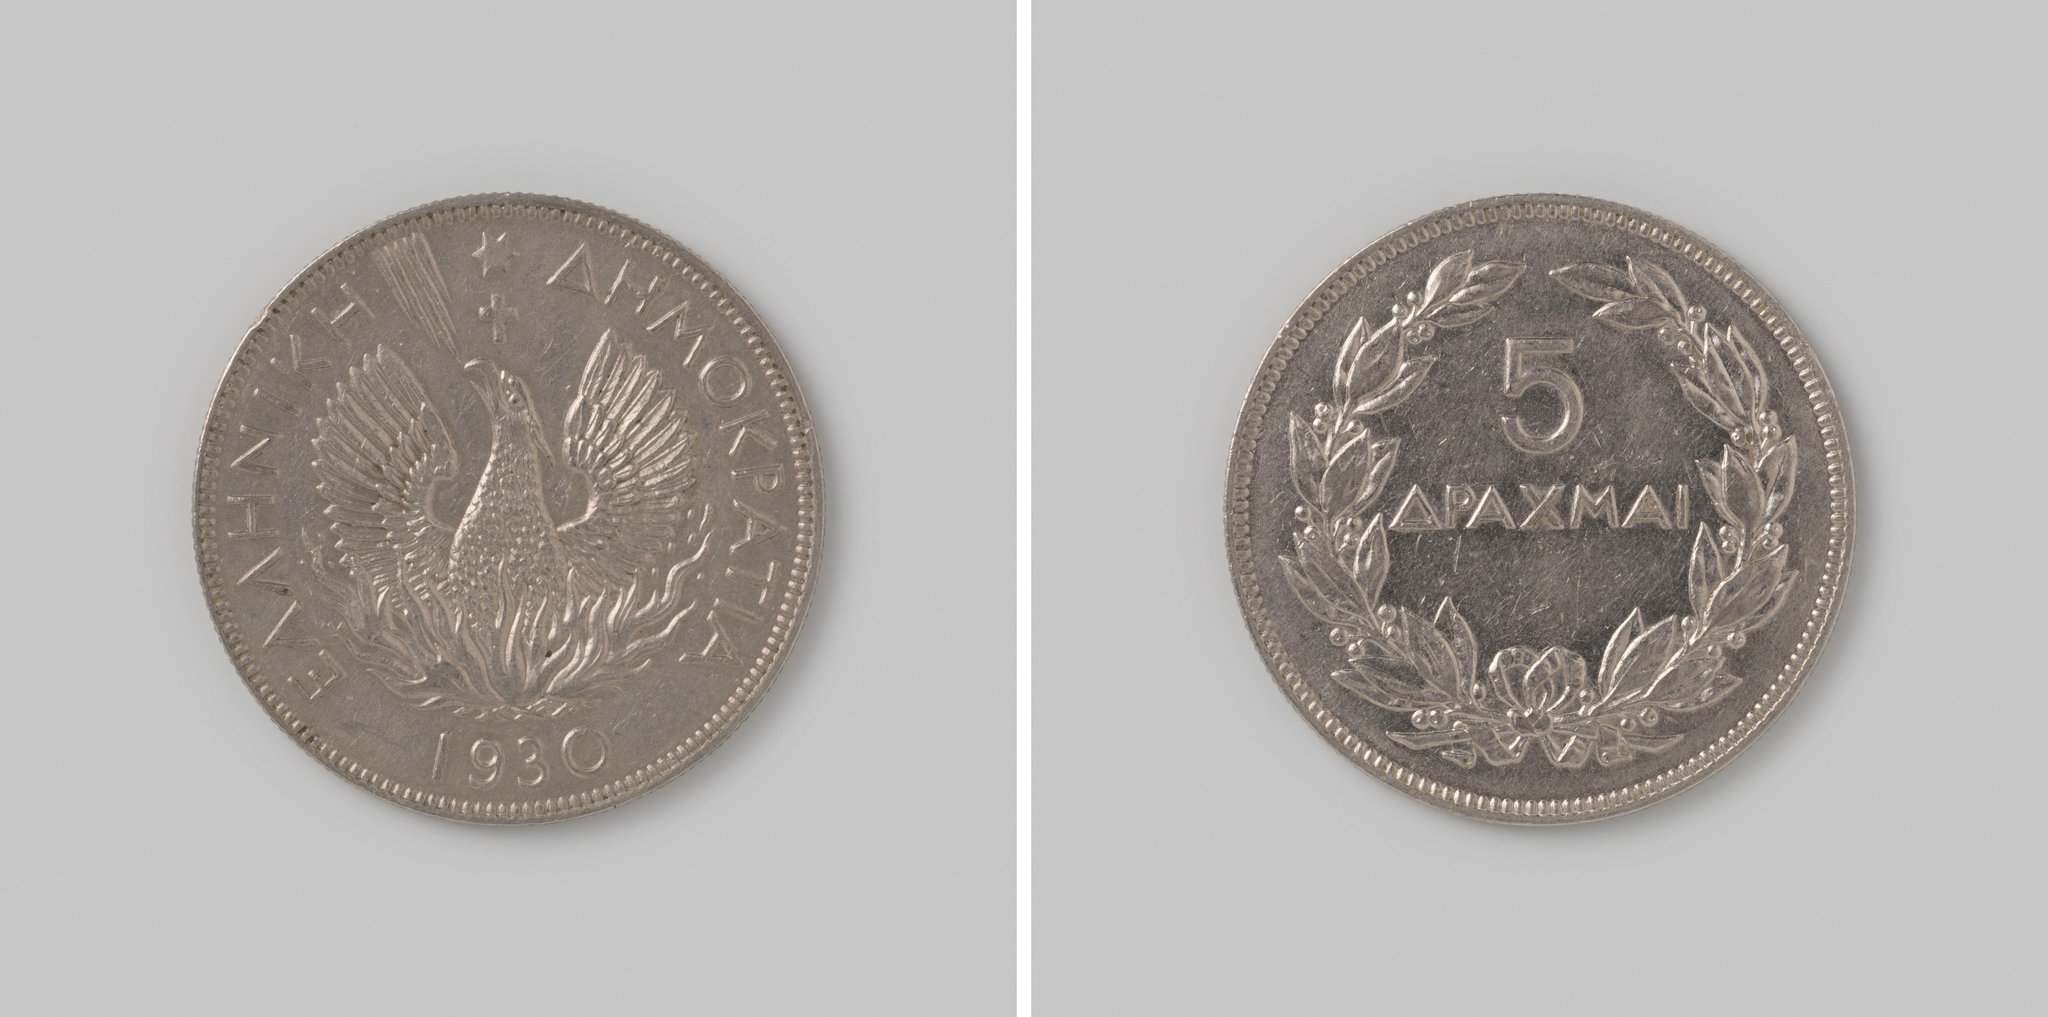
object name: coin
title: Griekenland, 5 drachmen, 1930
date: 1930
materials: nickel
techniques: striking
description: Koper-nikkelen munt. Voorzijde: uit vlammen oprijzende vogel Phoenix met gespreide vleugels en de kop gewend naar van links komende bliksemschicht. Bover Phoenix een kruis. Jaartal onderaan. Keerzijde: waarde-aanduiding in twee regels. Kartelrand.